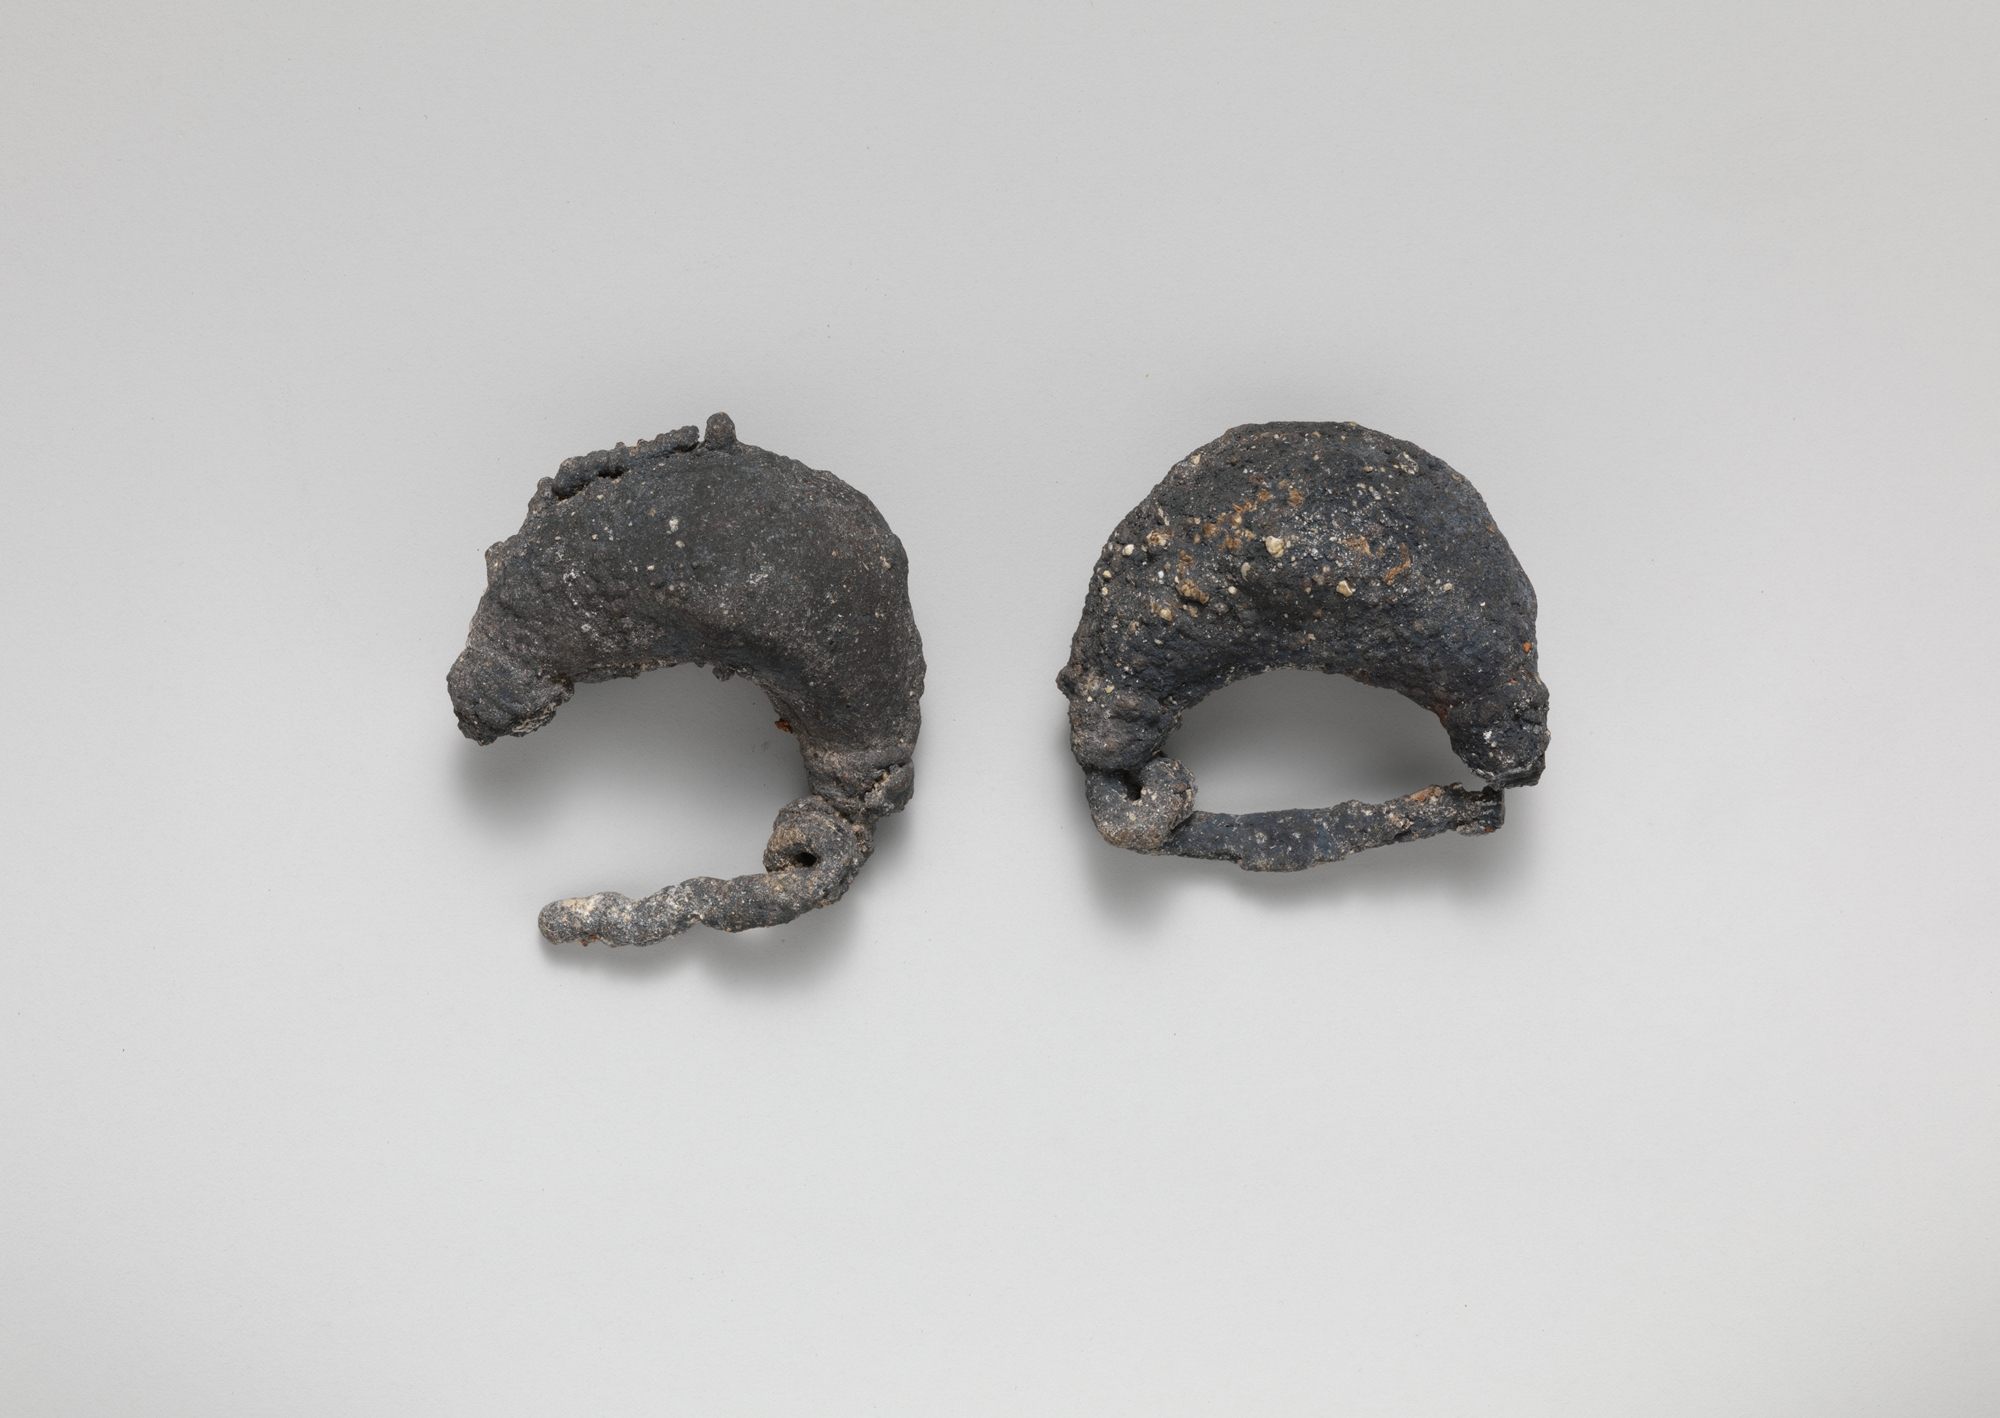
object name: fibula, sanguisuga type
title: Silver sanguisuga-type fibula (safety pin)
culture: italic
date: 800-601 BCE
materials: silver